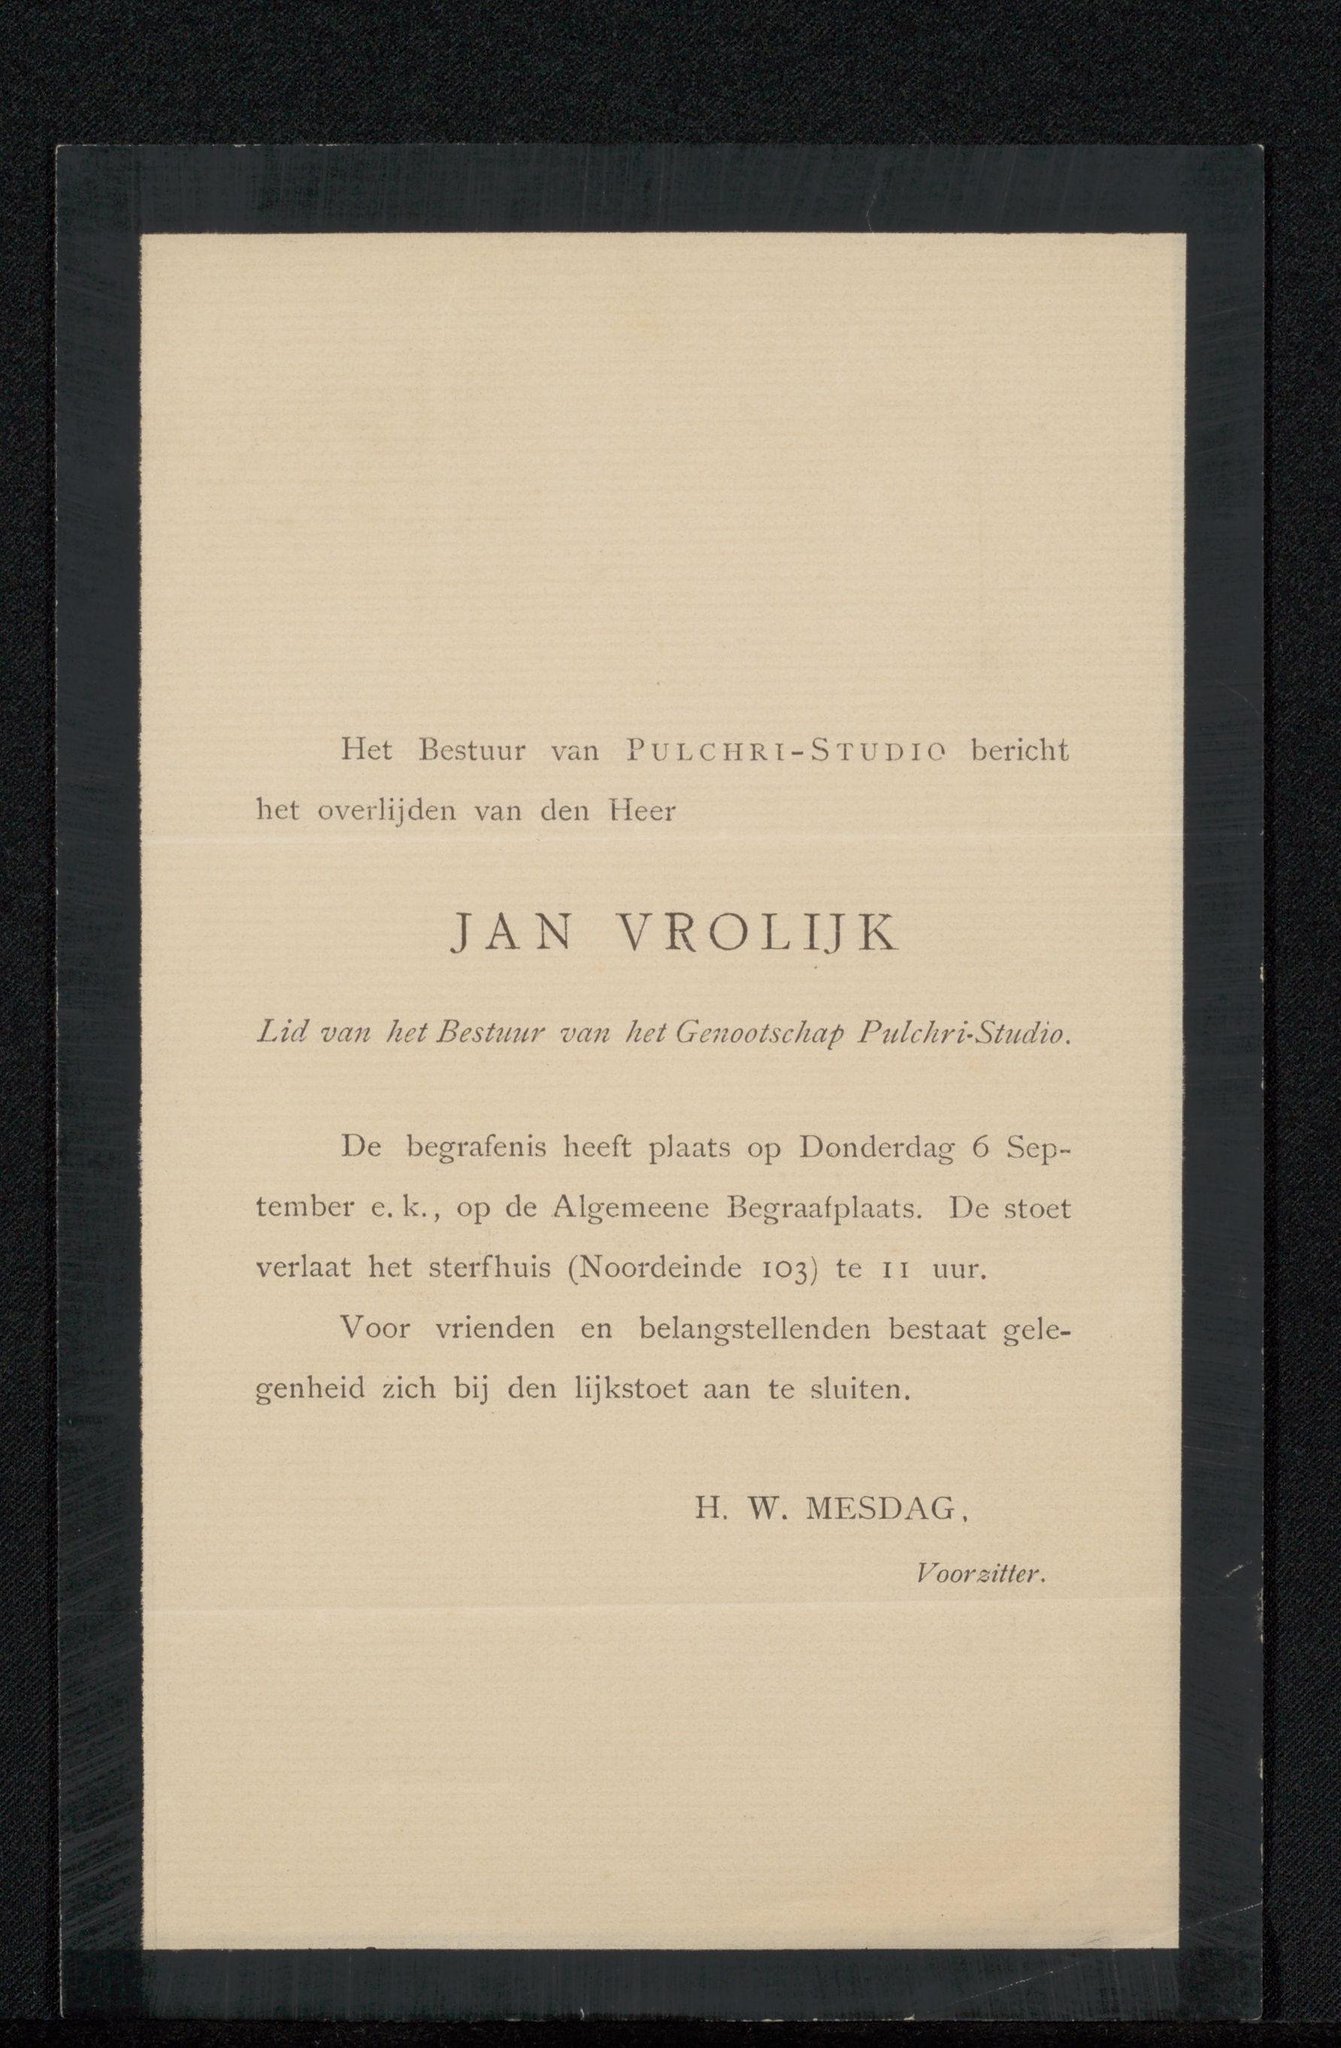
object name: overlijdensbericht, overlijdensadvertentie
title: Overlijdensbericht aan Philip Zilcken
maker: hendrik willem mesdag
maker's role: draughtsman, painter, print maker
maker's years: 1831-1915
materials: paper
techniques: printing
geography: the hague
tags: print maker, jan vrolijk, the hague, painter, draughtsman, philip zilcken